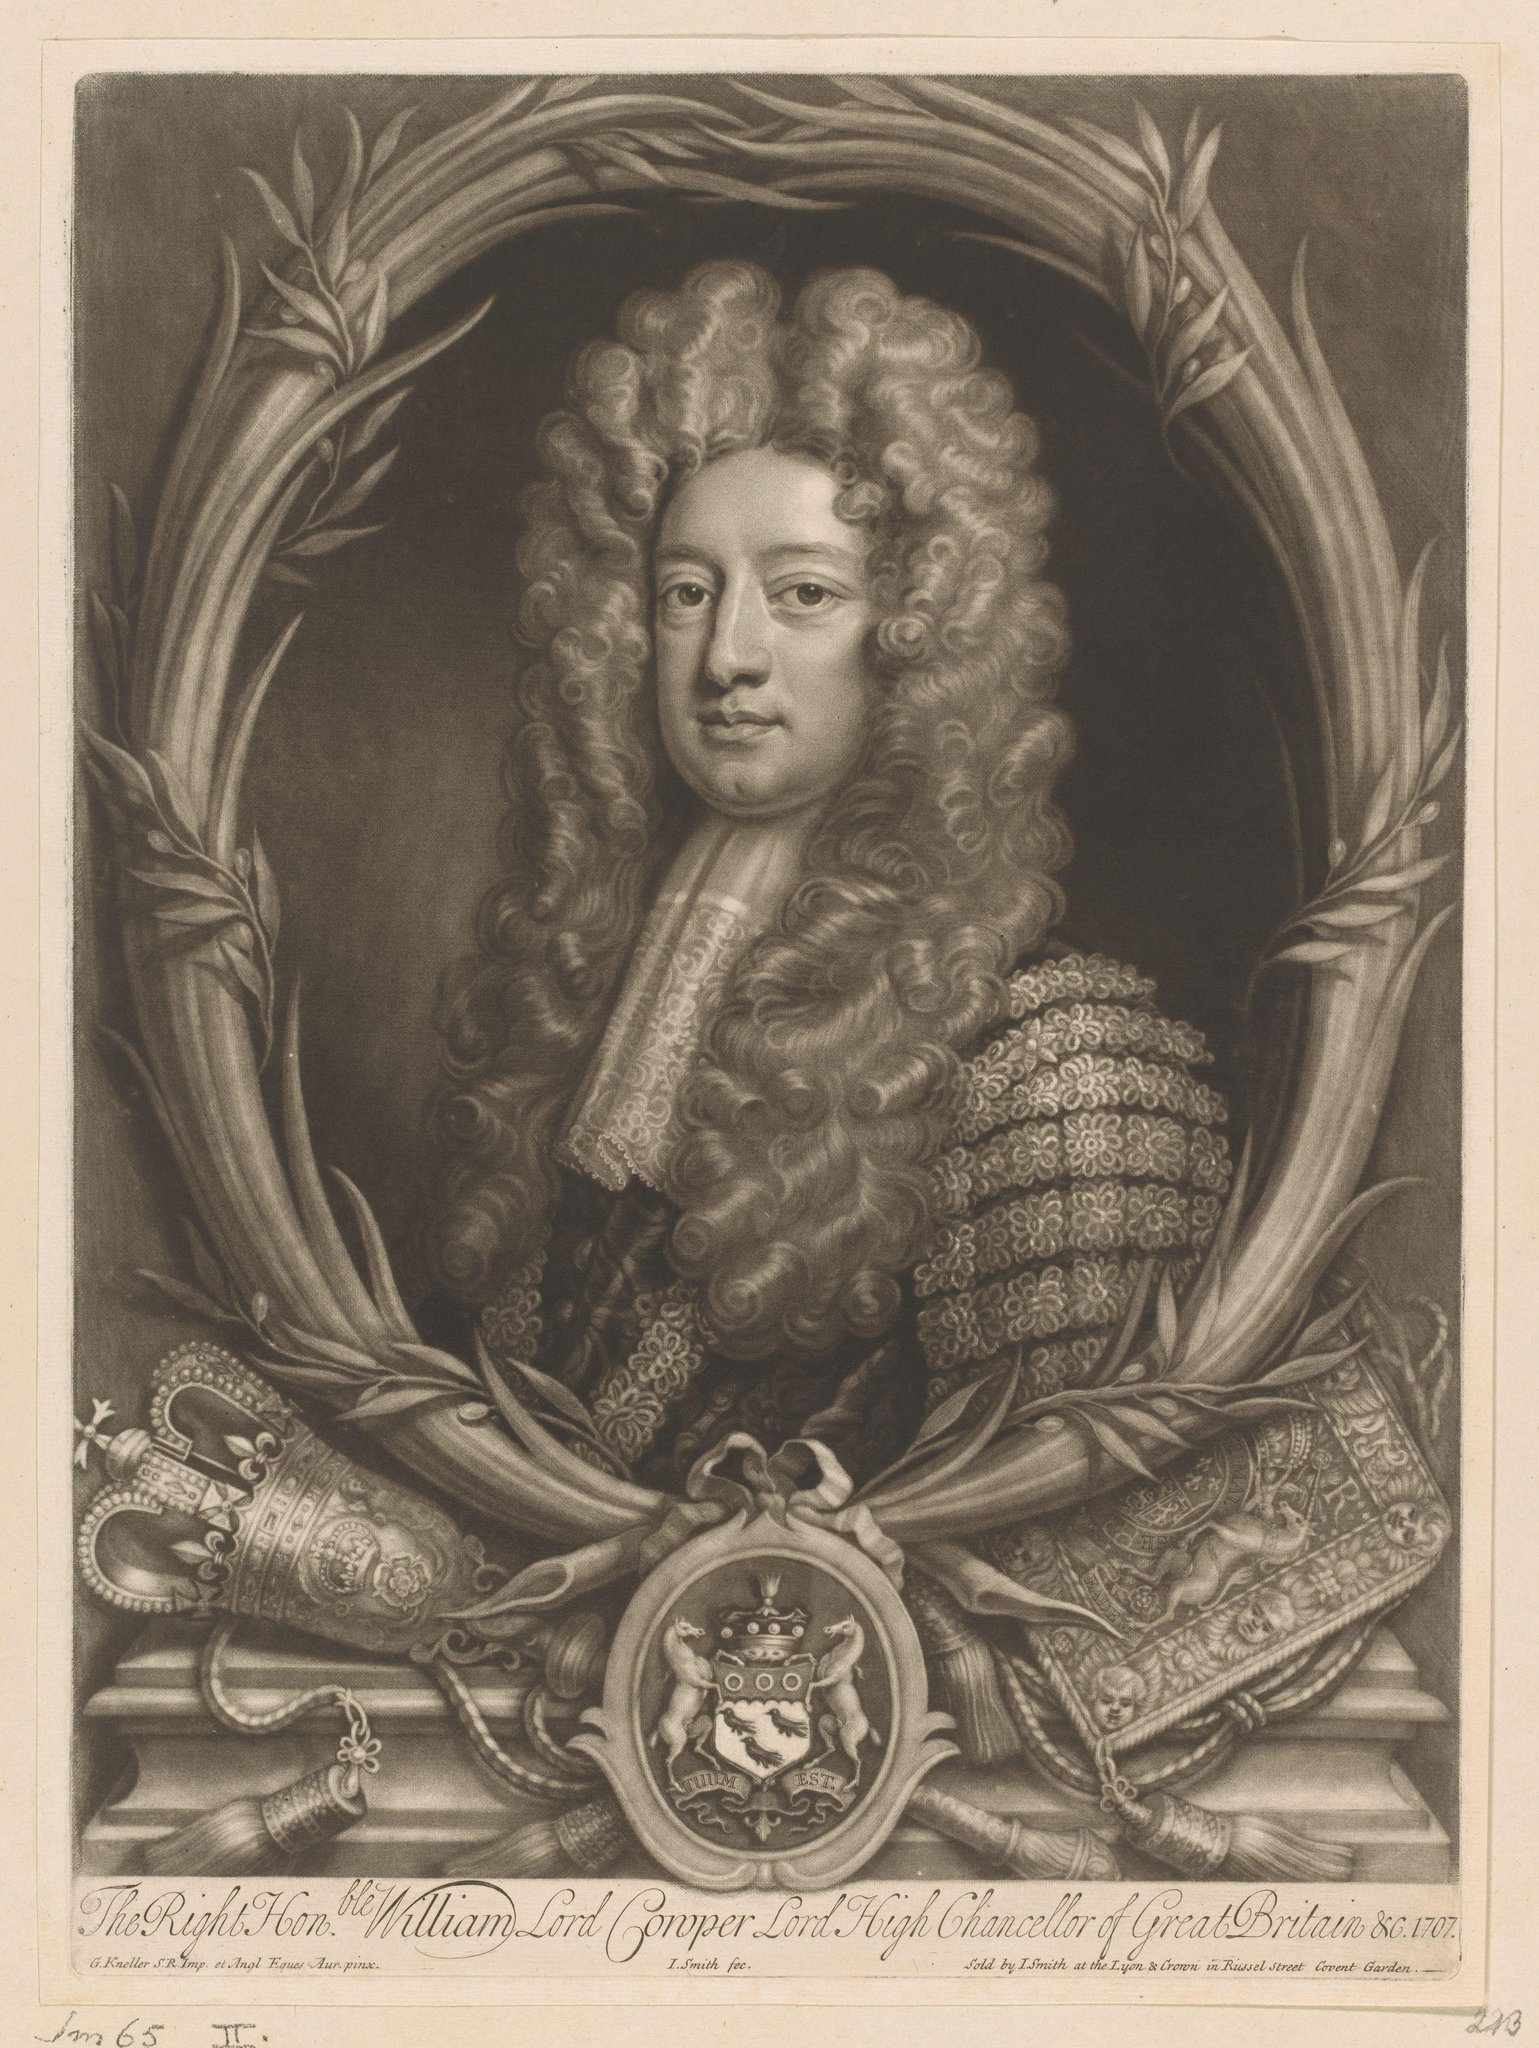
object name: print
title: Portret van William Cowper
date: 1707-1742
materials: paper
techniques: mezzotint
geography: london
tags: earl, historical persons, politician, e.g. party leader, insignia and symbols of sovereignty (crown, diadem, sceptre, orb, seal, standard, cloak, pectoral)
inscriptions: collector's mark: Lugt 240